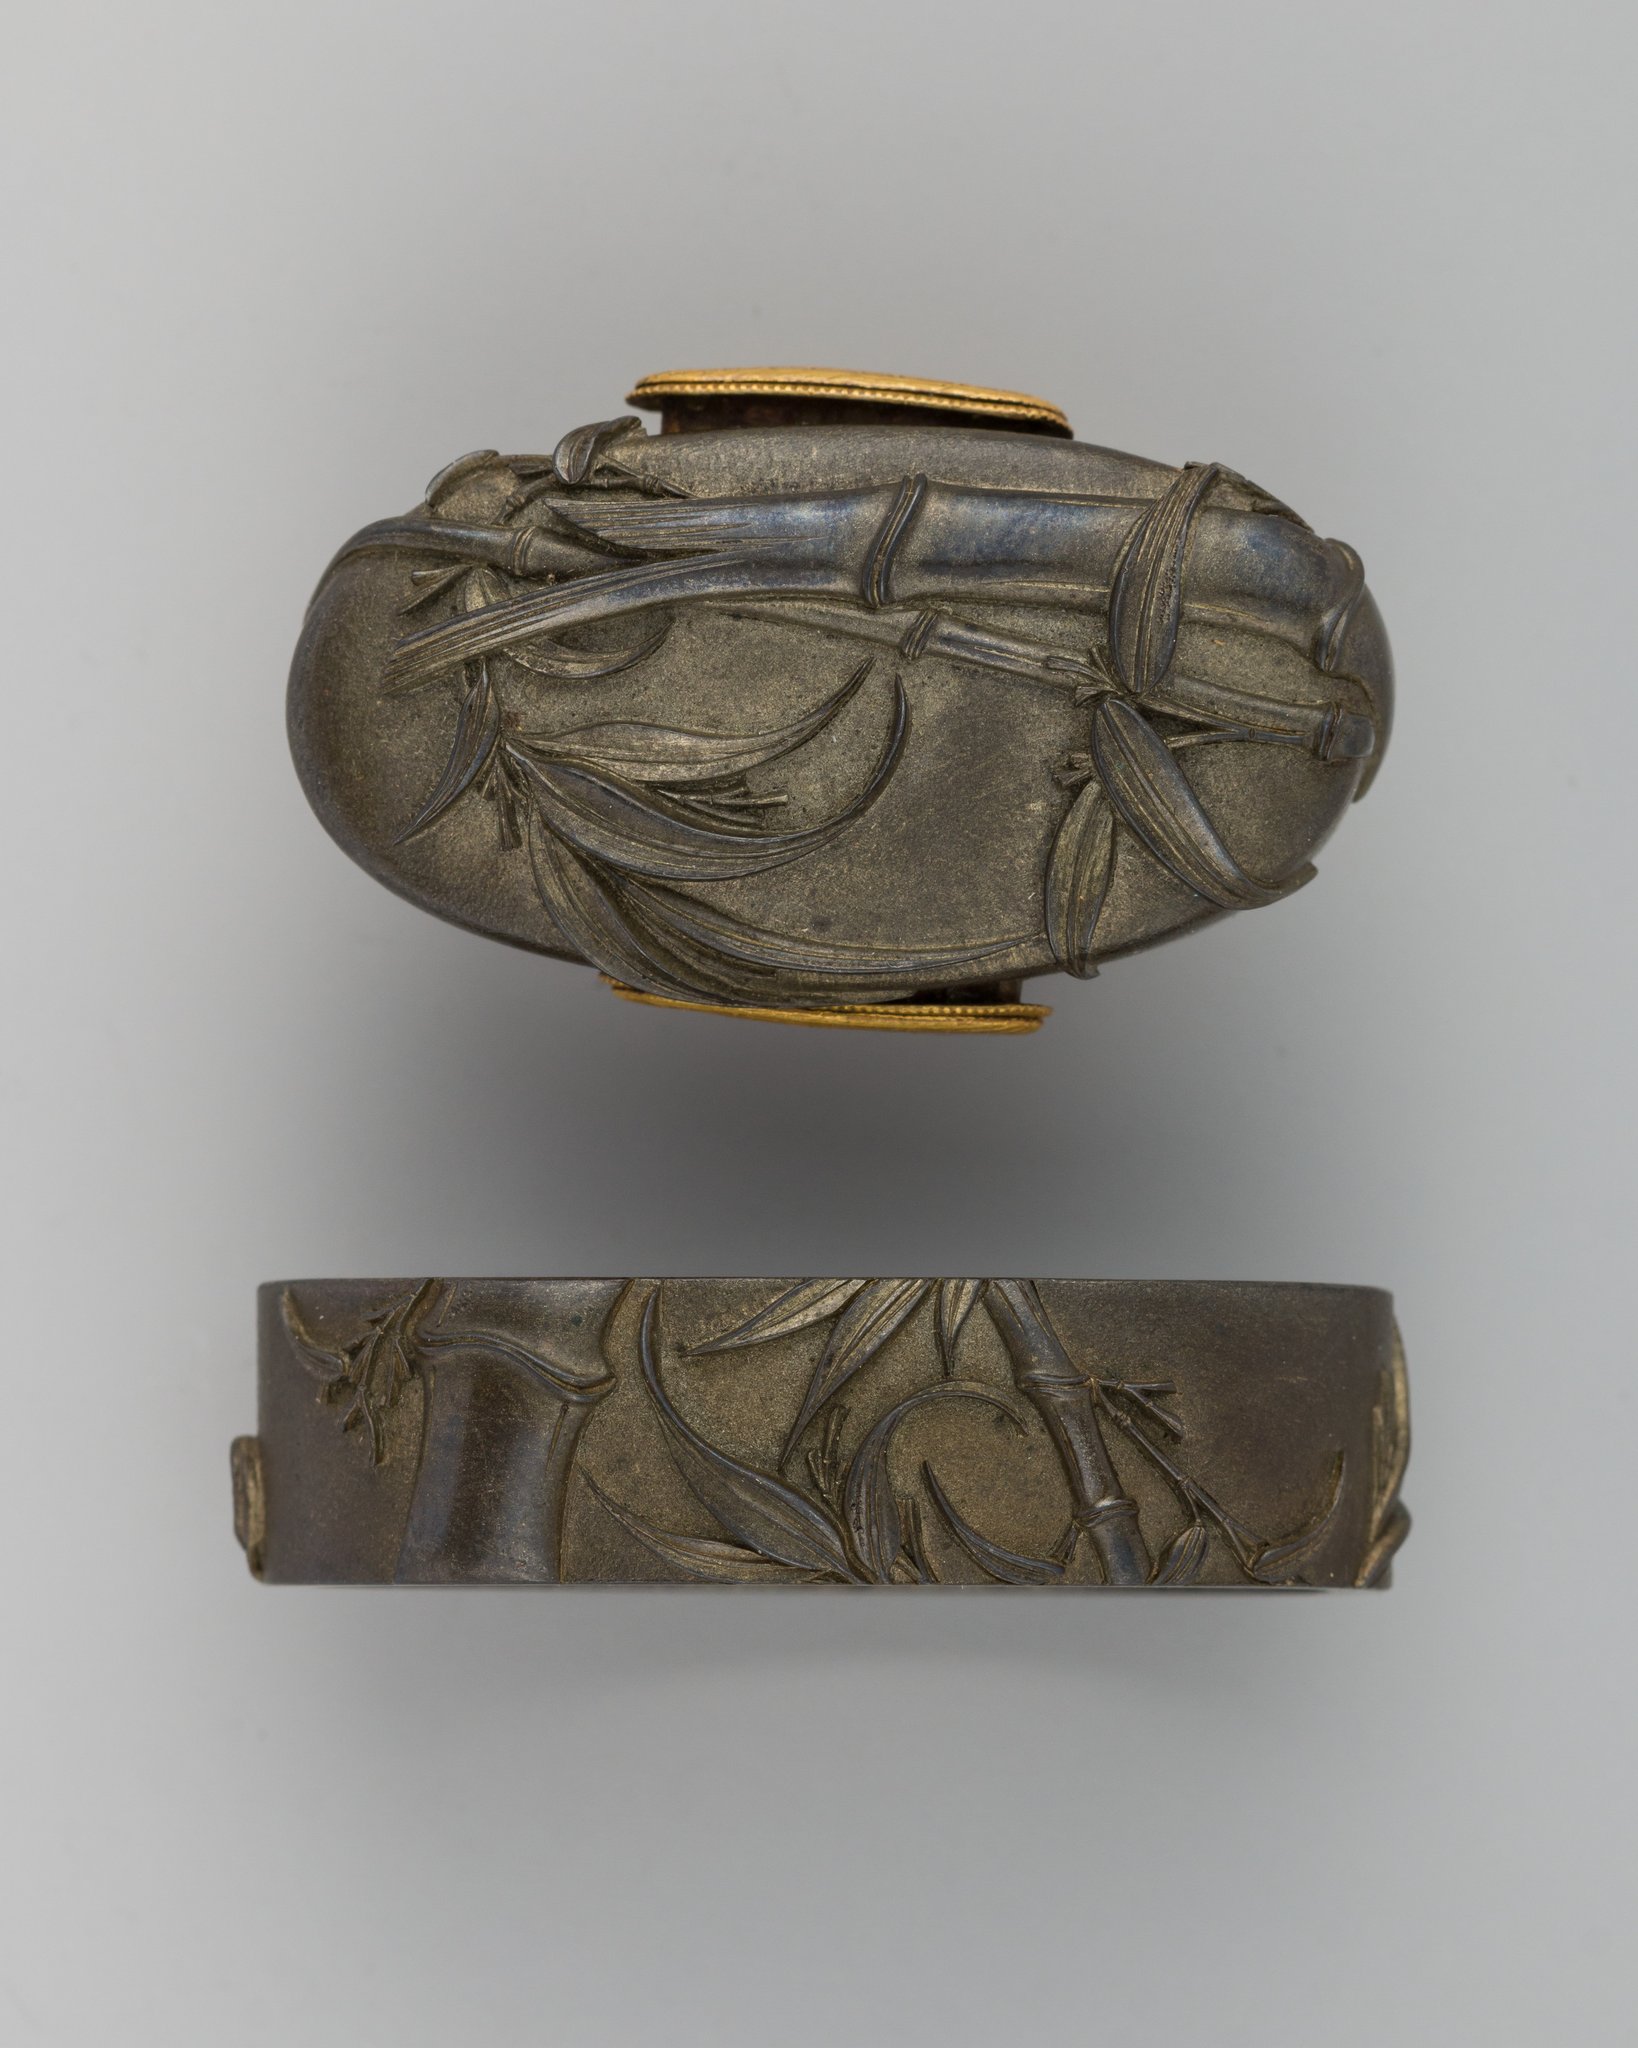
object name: sword hilt collar and pommel fuchigashira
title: Sword-Hilt Collar and Pommel (Fuchigashira)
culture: japanese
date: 1615-1868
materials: silver alloy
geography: japan